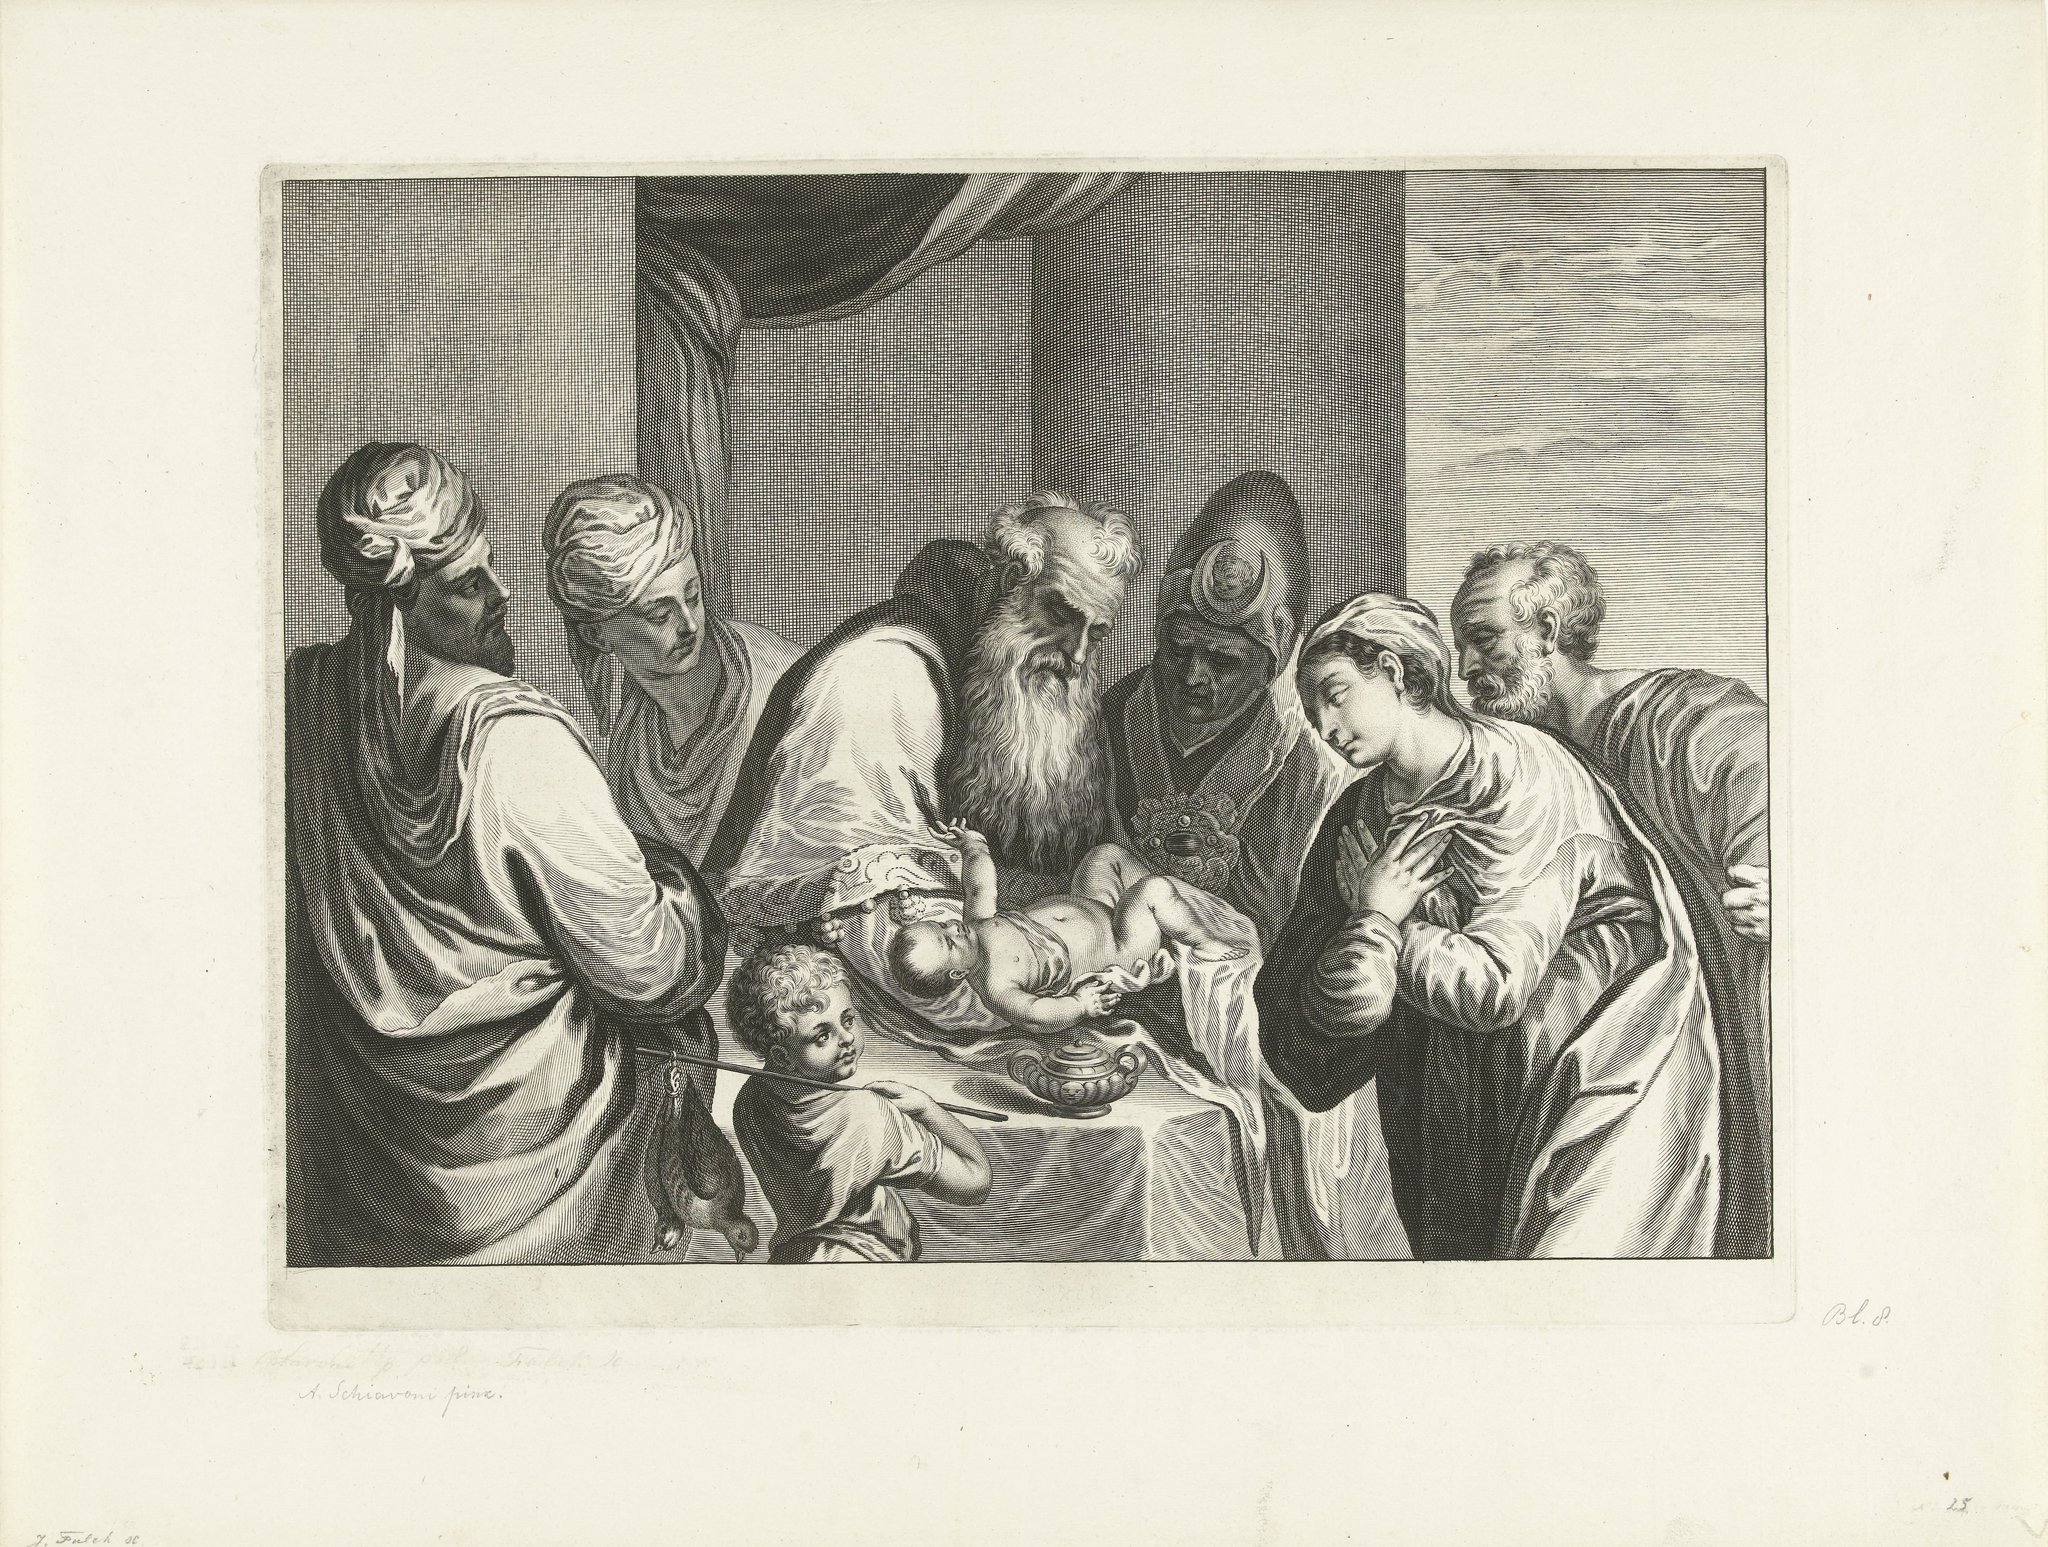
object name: print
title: Presentatie van Christus in de tempel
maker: jeremias falck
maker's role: print maker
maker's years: 1609-1677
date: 1655-1677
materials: paper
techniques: engraving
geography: italy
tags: presentation of the christ-child in the temple, usually simeon (and anna) present (luke 2:22-39)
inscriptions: collector's mark: Lugt 2165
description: De hogepriester houdt Christus boven een tafel in zijn armen. Een kind en vijf volwassenen waaronder Jozef en Maria, kijken toe.